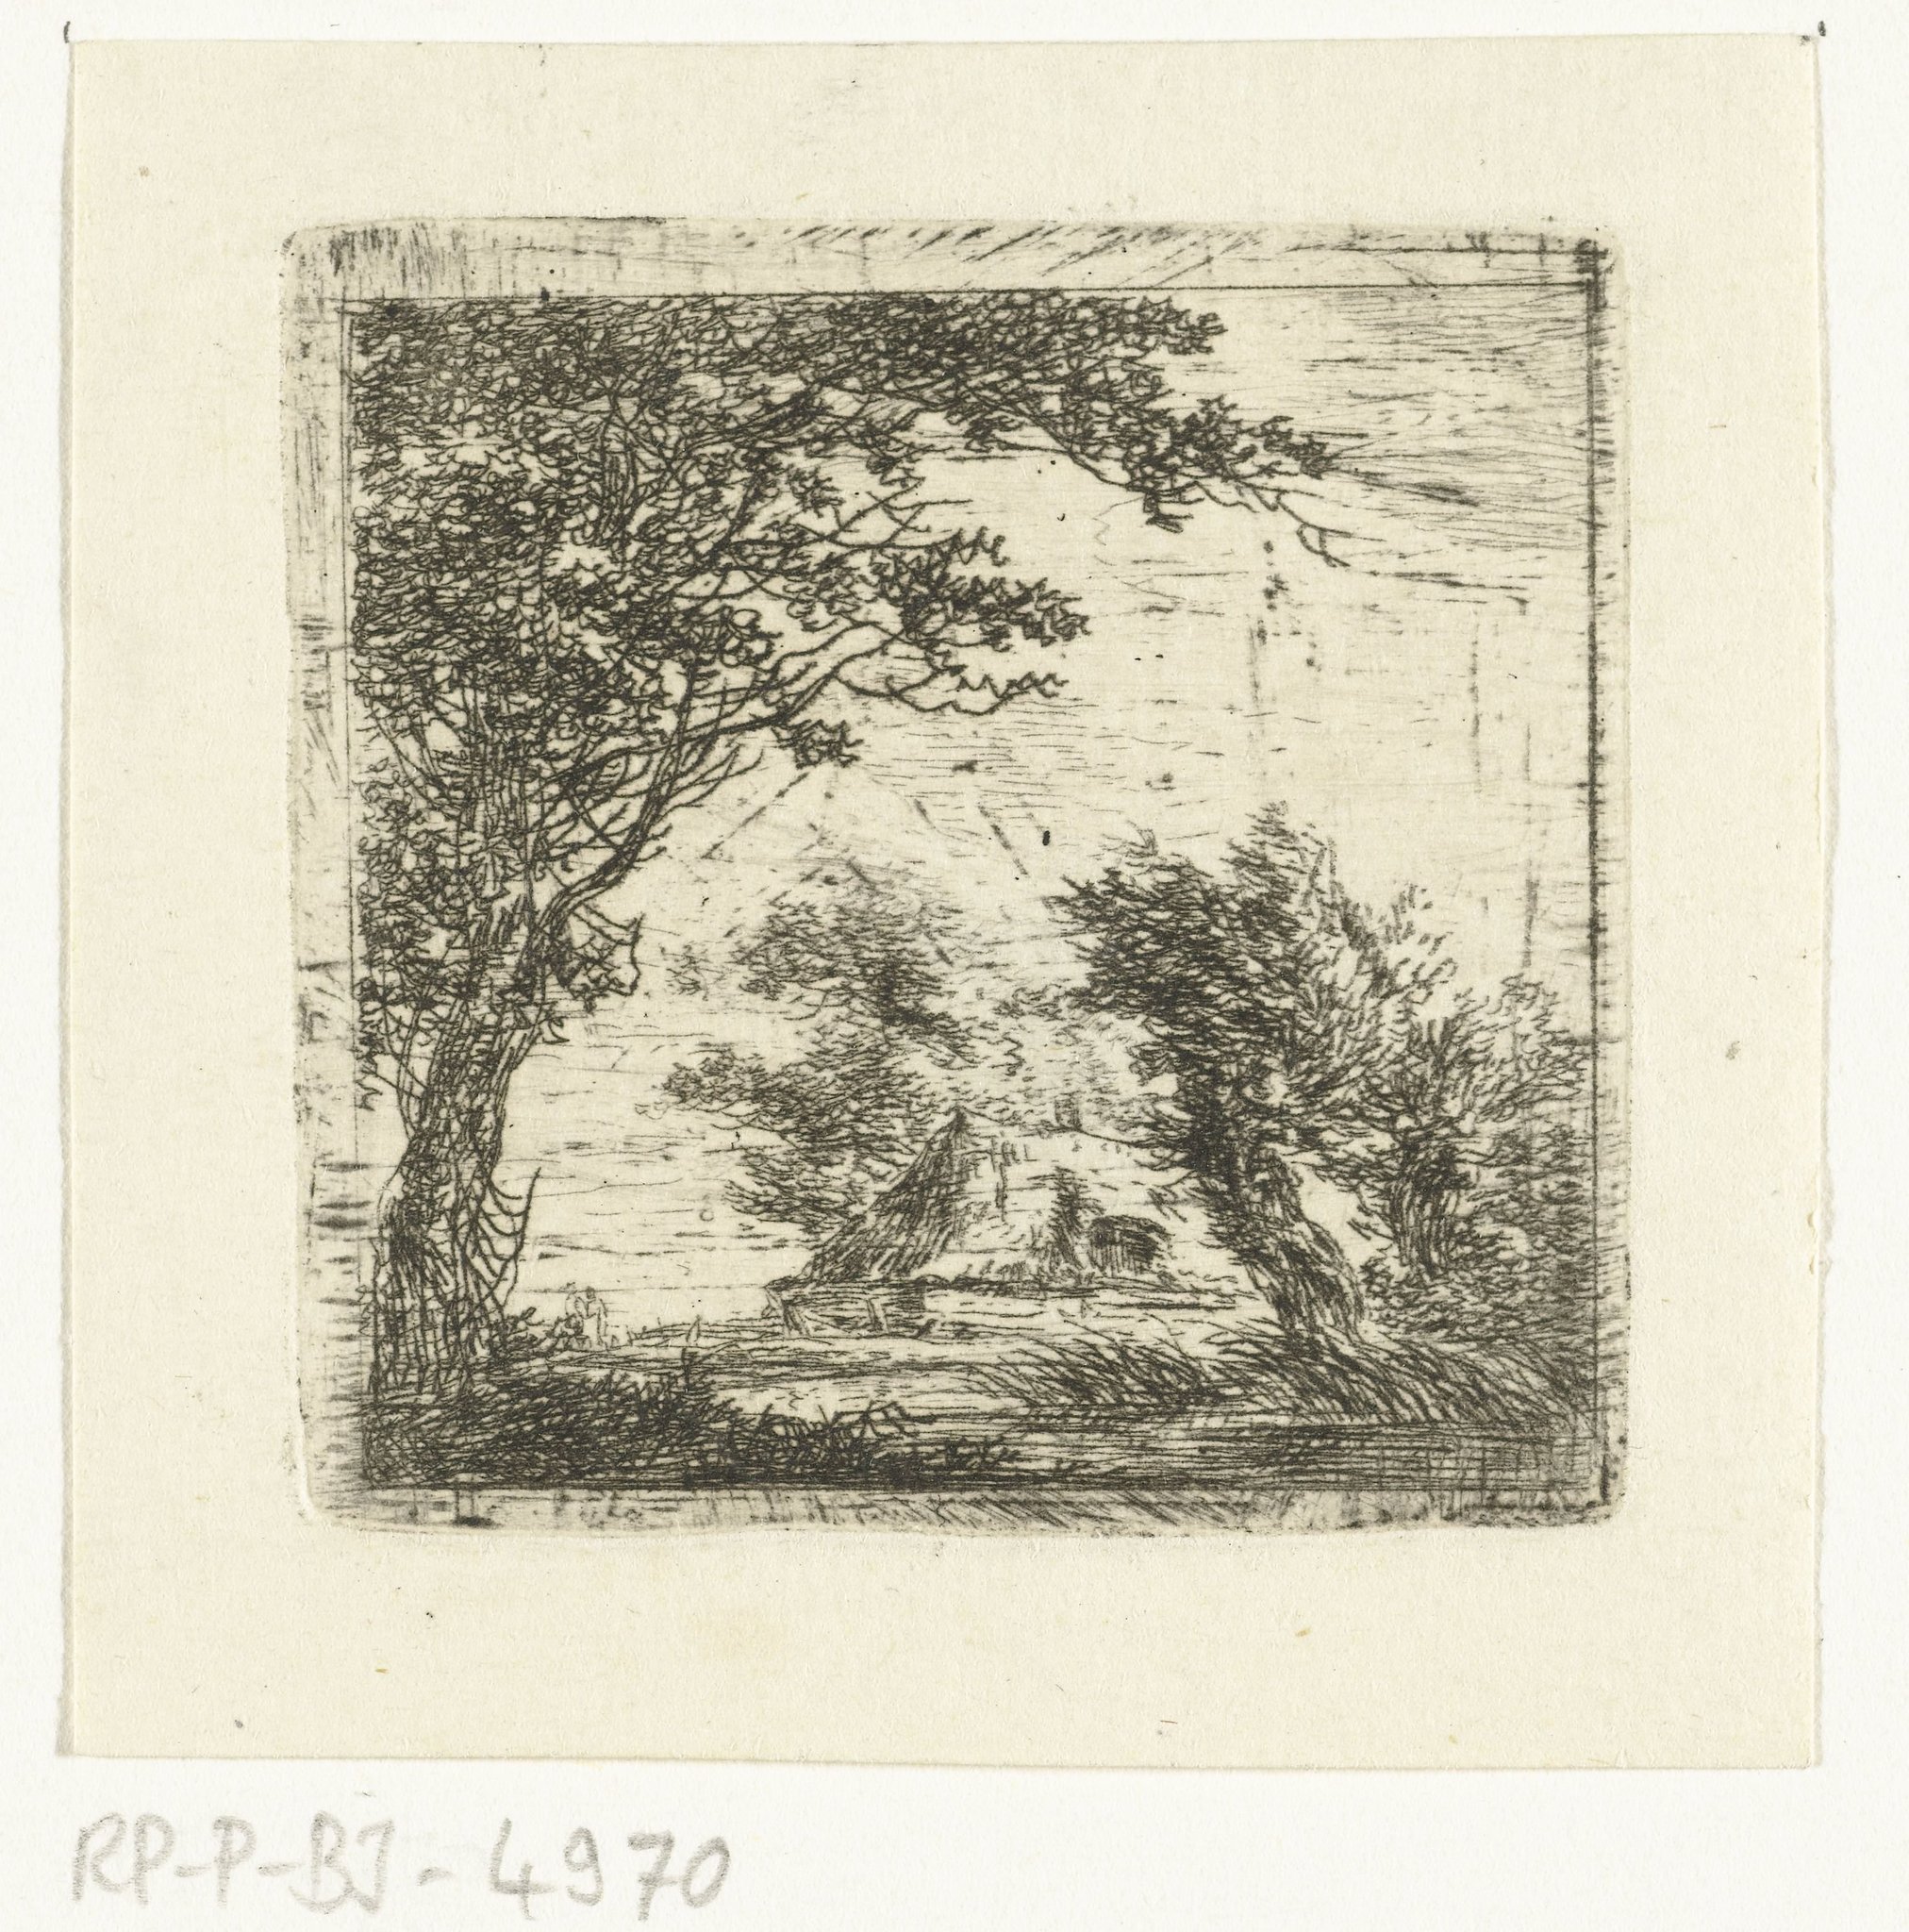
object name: print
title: Boerenwoning tussen bomen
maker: hermanus van brussel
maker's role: draughtsman, print maker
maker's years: 1763-1815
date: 1800-1815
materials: paper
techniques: etching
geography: netherlands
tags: landscapes in the temperate zone, farm or solitary house in landscape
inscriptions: collector's mark: Lugt 2228